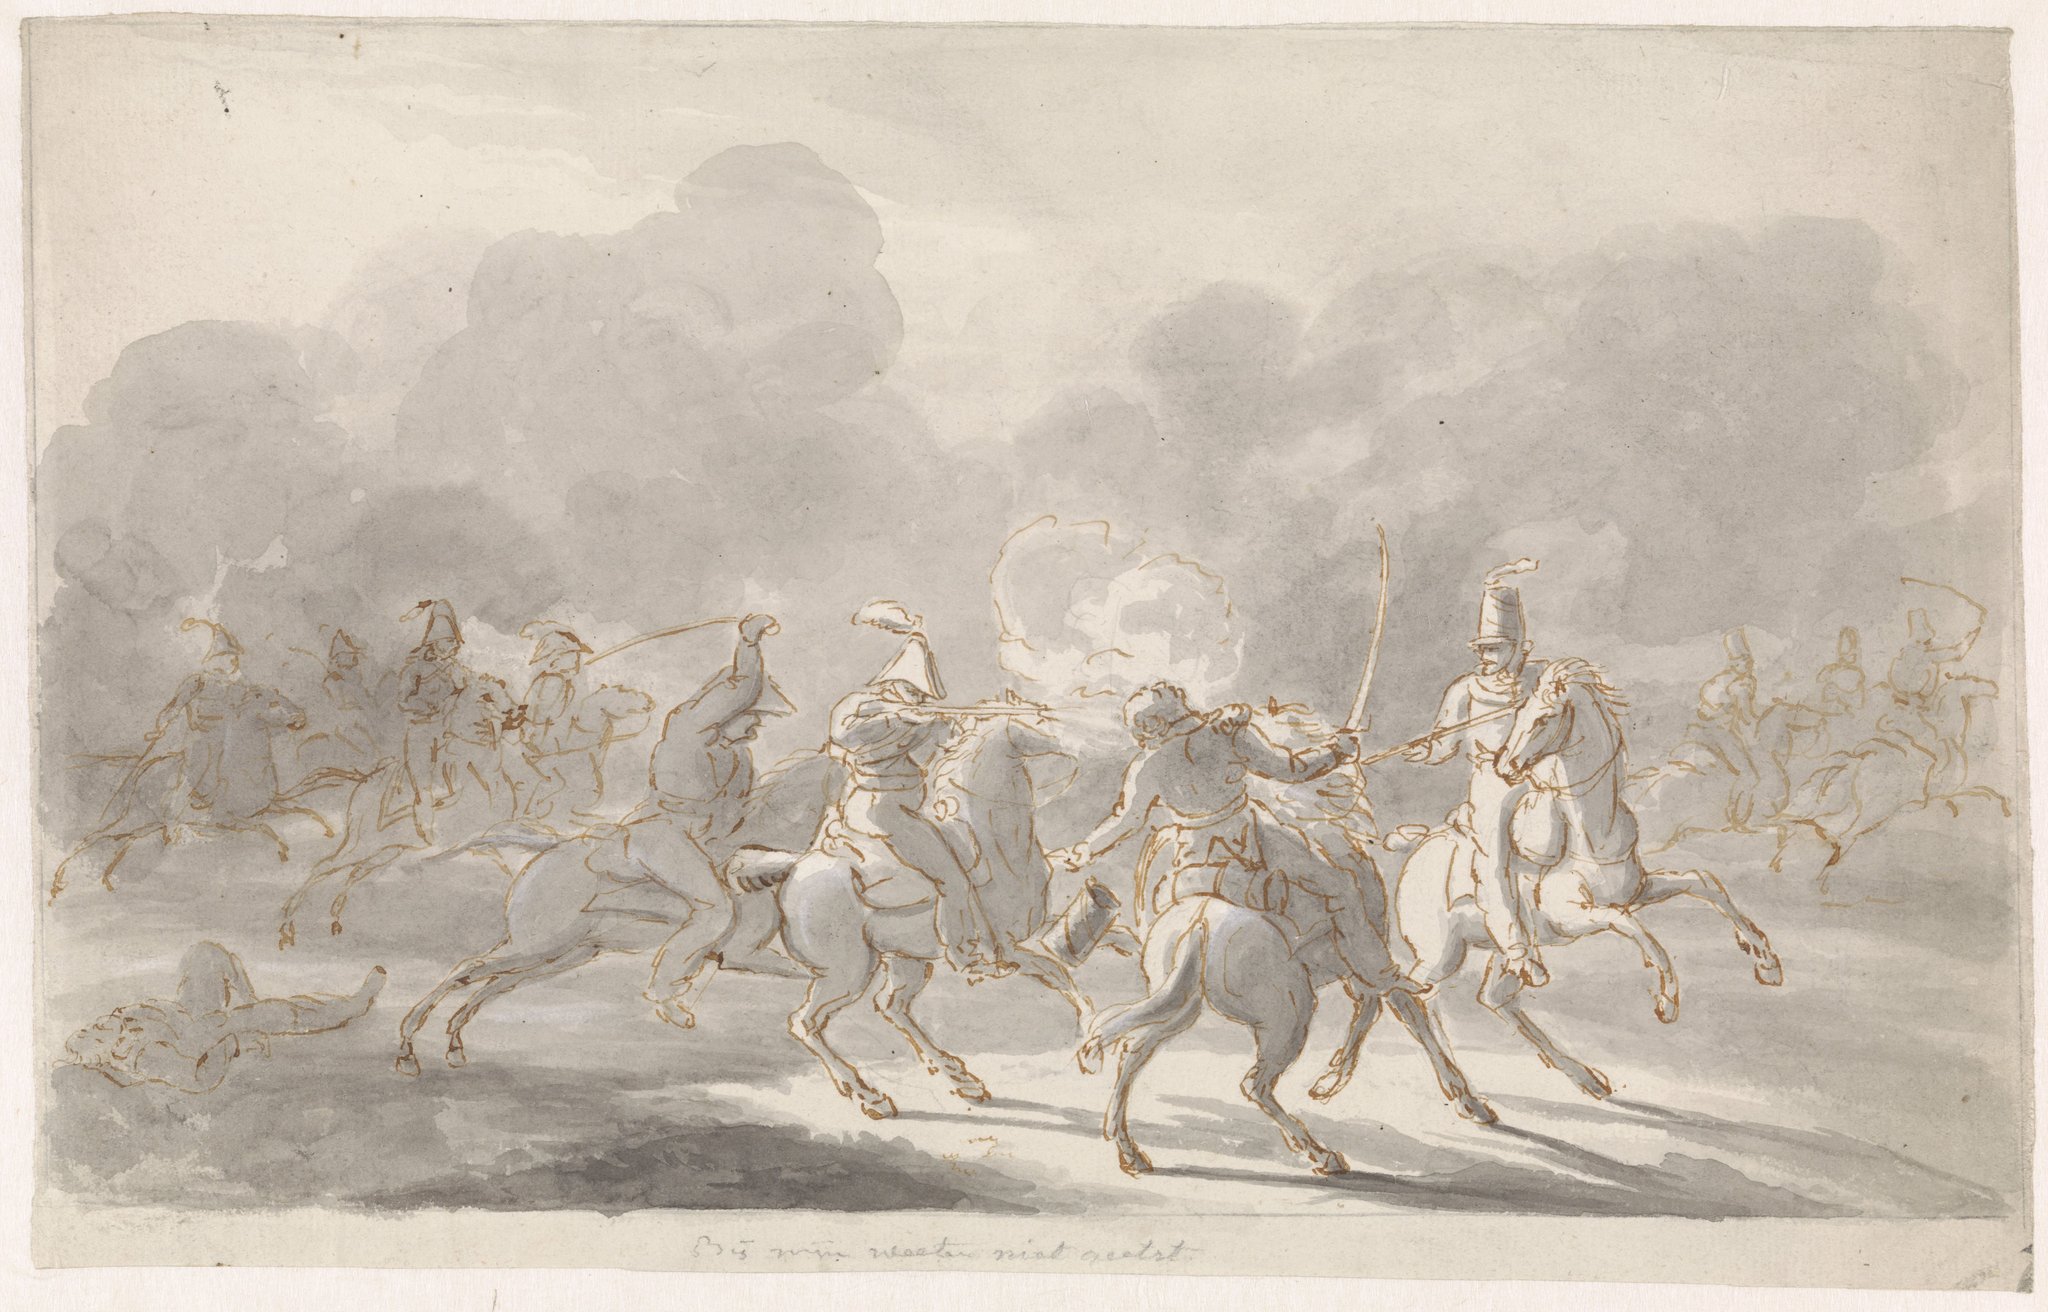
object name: drawing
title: Ruitergevecht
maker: gerardus emaus de micault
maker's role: draughtsman, print maker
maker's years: 1798-1863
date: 1799-1863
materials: ink, paper, pencil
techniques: brush, pen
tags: battle (+ cavalry, horsemen)